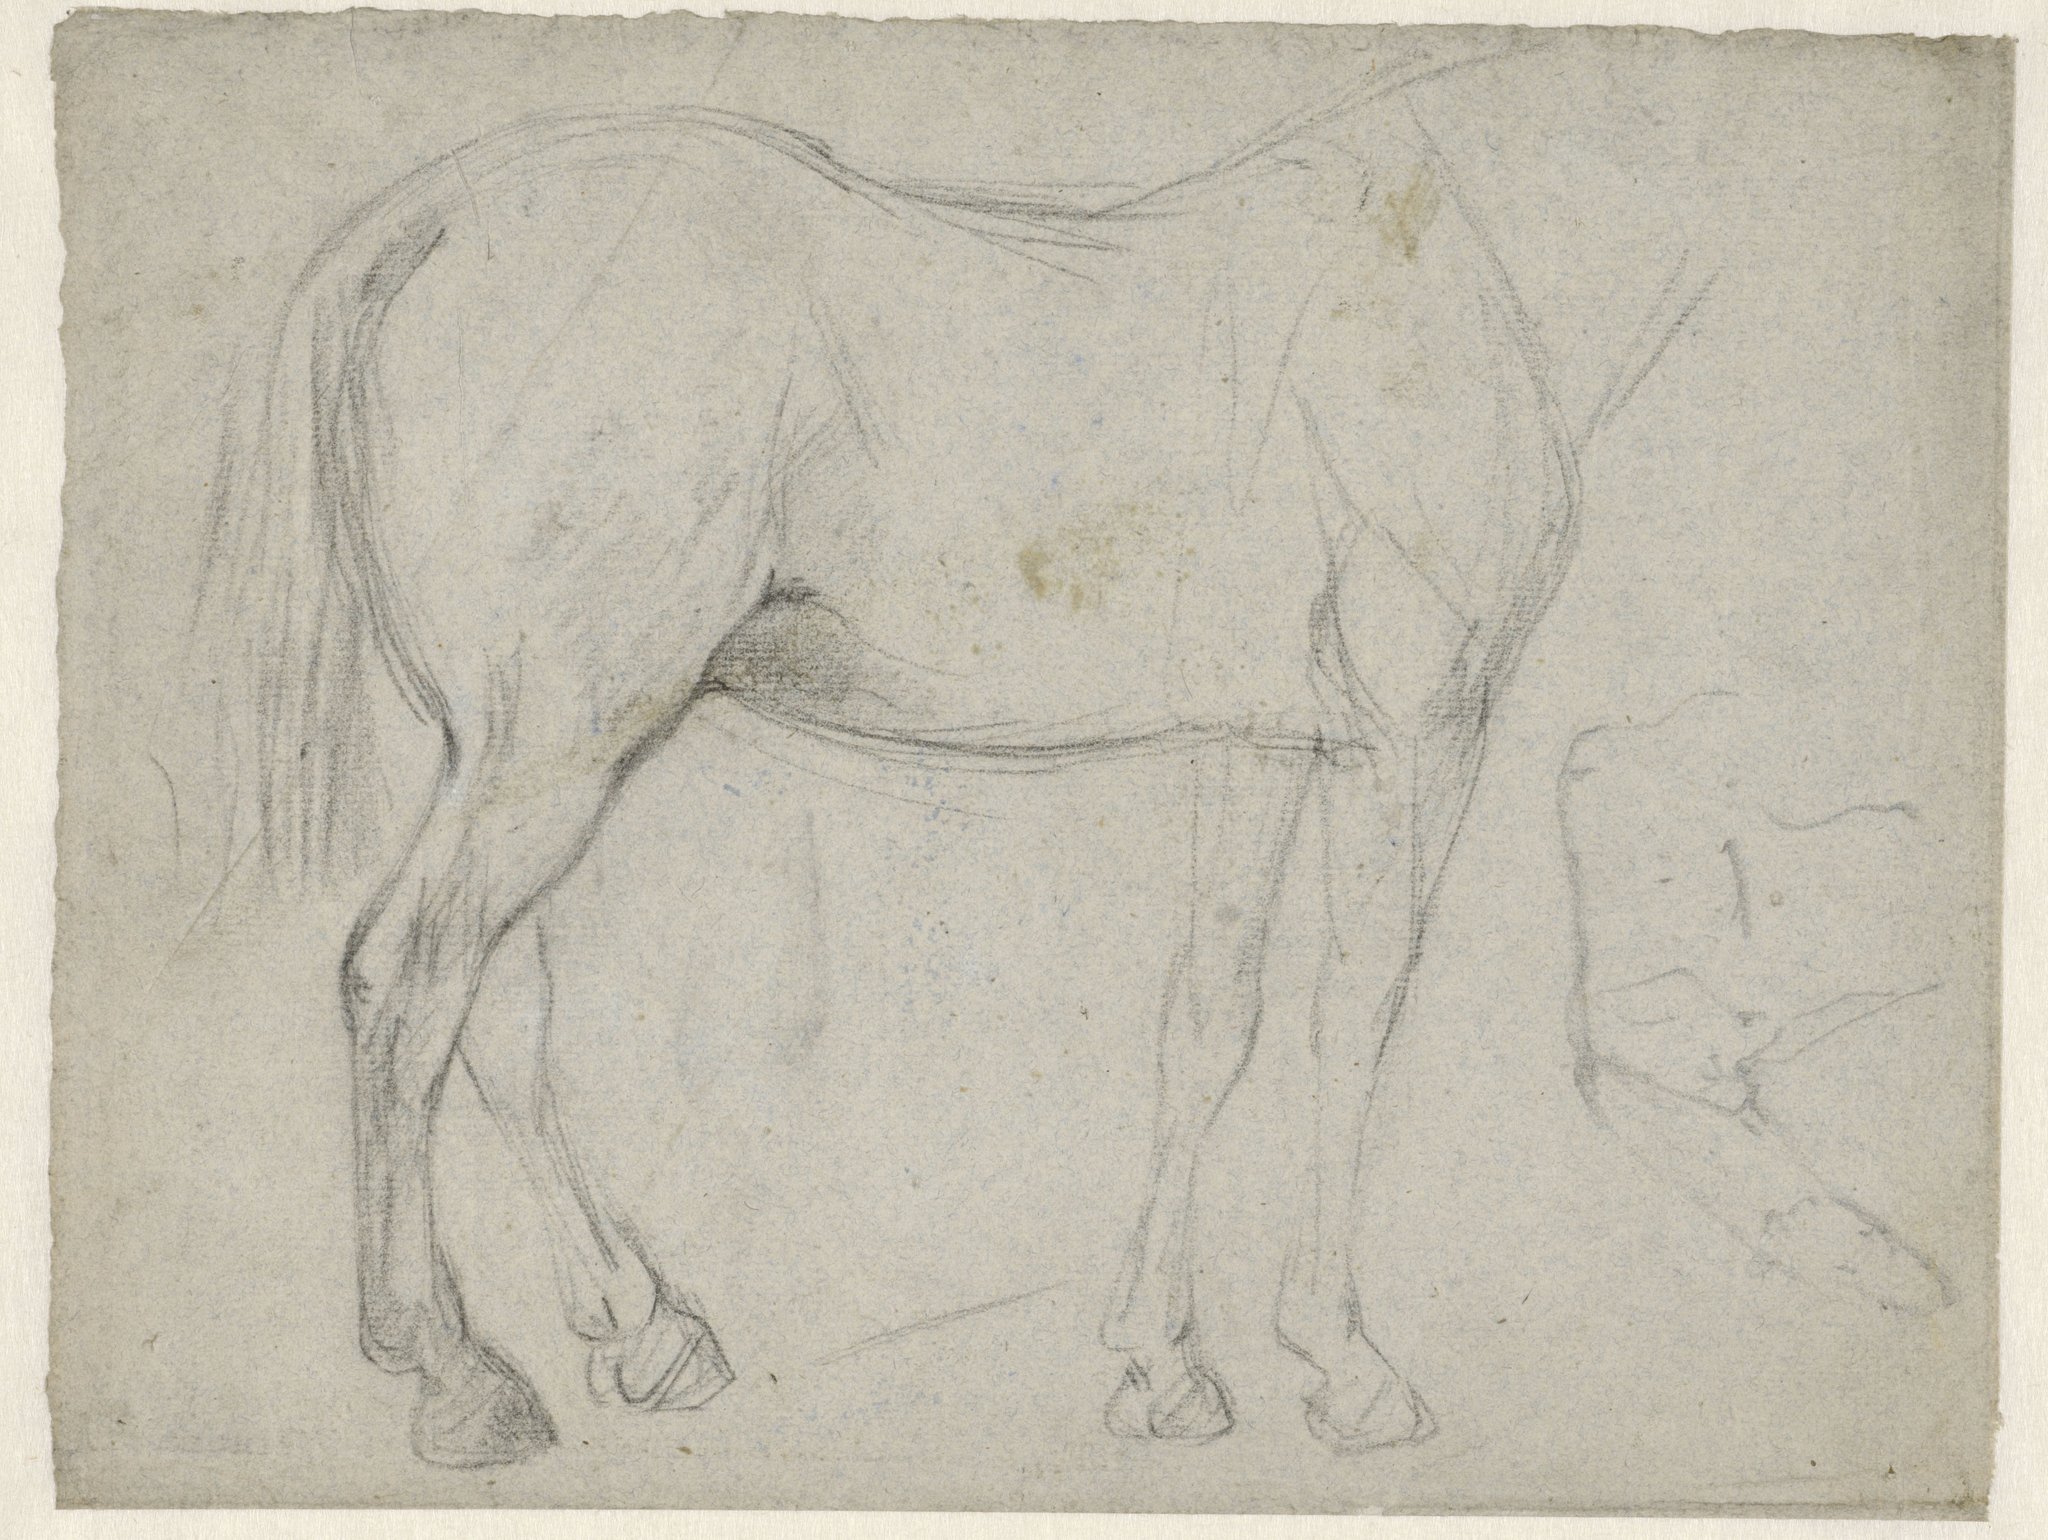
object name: drawing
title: Studies van een paard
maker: jan kuyper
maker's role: draughtsman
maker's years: 1845-1912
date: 1855-1912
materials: chalk, paper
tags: horse